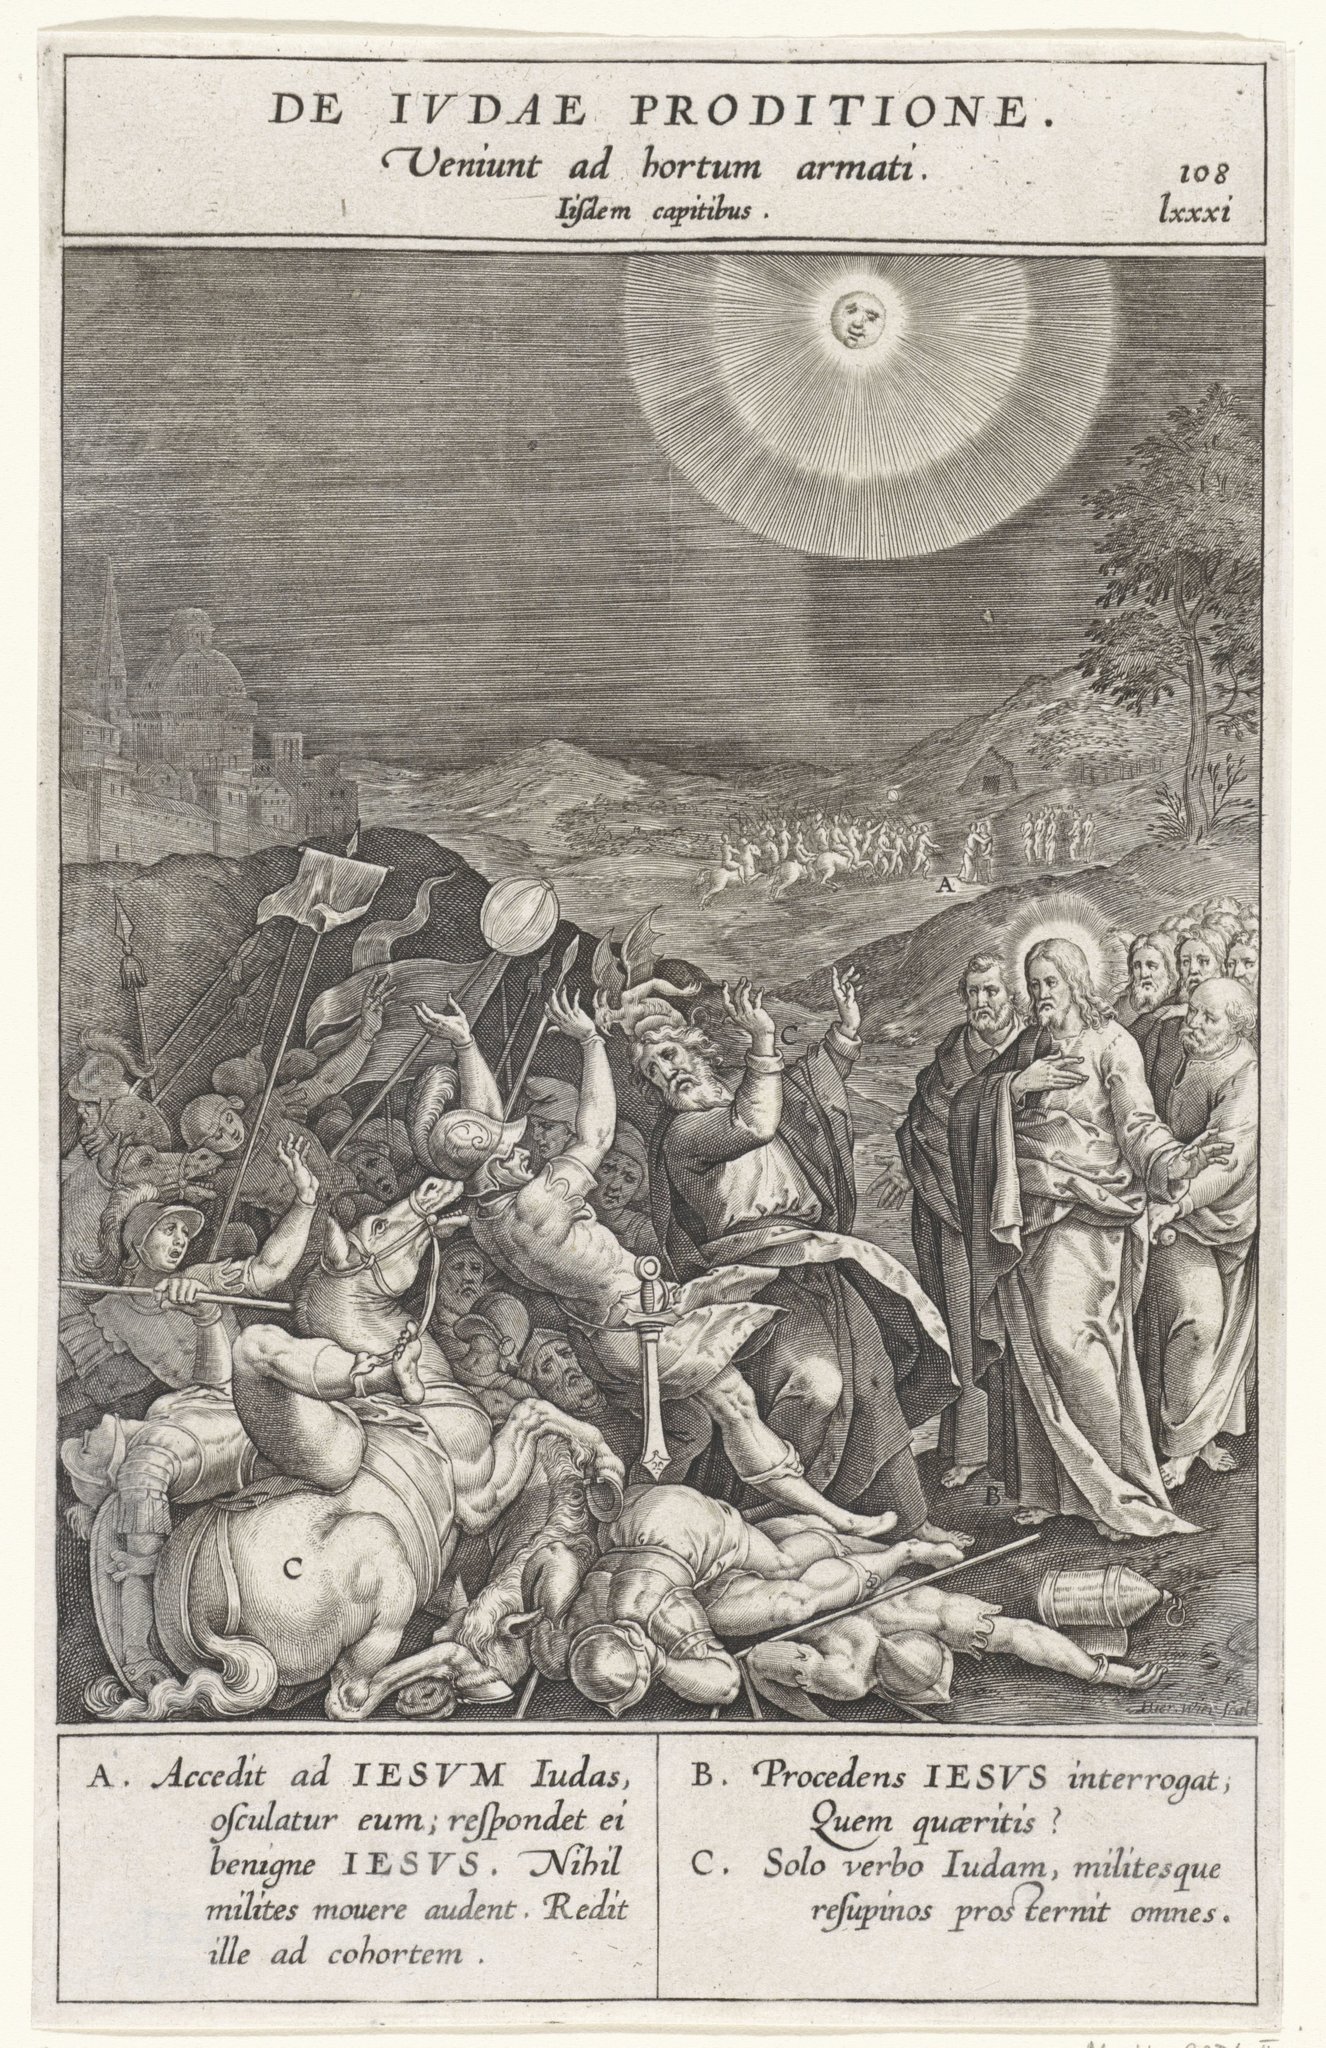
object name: print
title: De Ivdae Proditione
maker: hieronymus wierix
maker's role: draughtsman, print maker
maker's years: 1553-1619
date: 1593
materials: paper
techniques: engraving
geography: antwerp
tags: the kiss of judas: accompanied by soldiers with torches and lanterns, he kisses christ, christ makes himself known; the soldiers fall to the ground ~ the kiss of judas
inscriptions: collector's mark: Lugt 2165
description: Judas - met duivel op het hoofd - leidt de soldaten naar Christus. Op de achtergrond is te zien hoe Judas Christus op de wang kust. Bij verschillende elementen uit de voorstelling staan letters die corresponderen met de legenda in de marge.